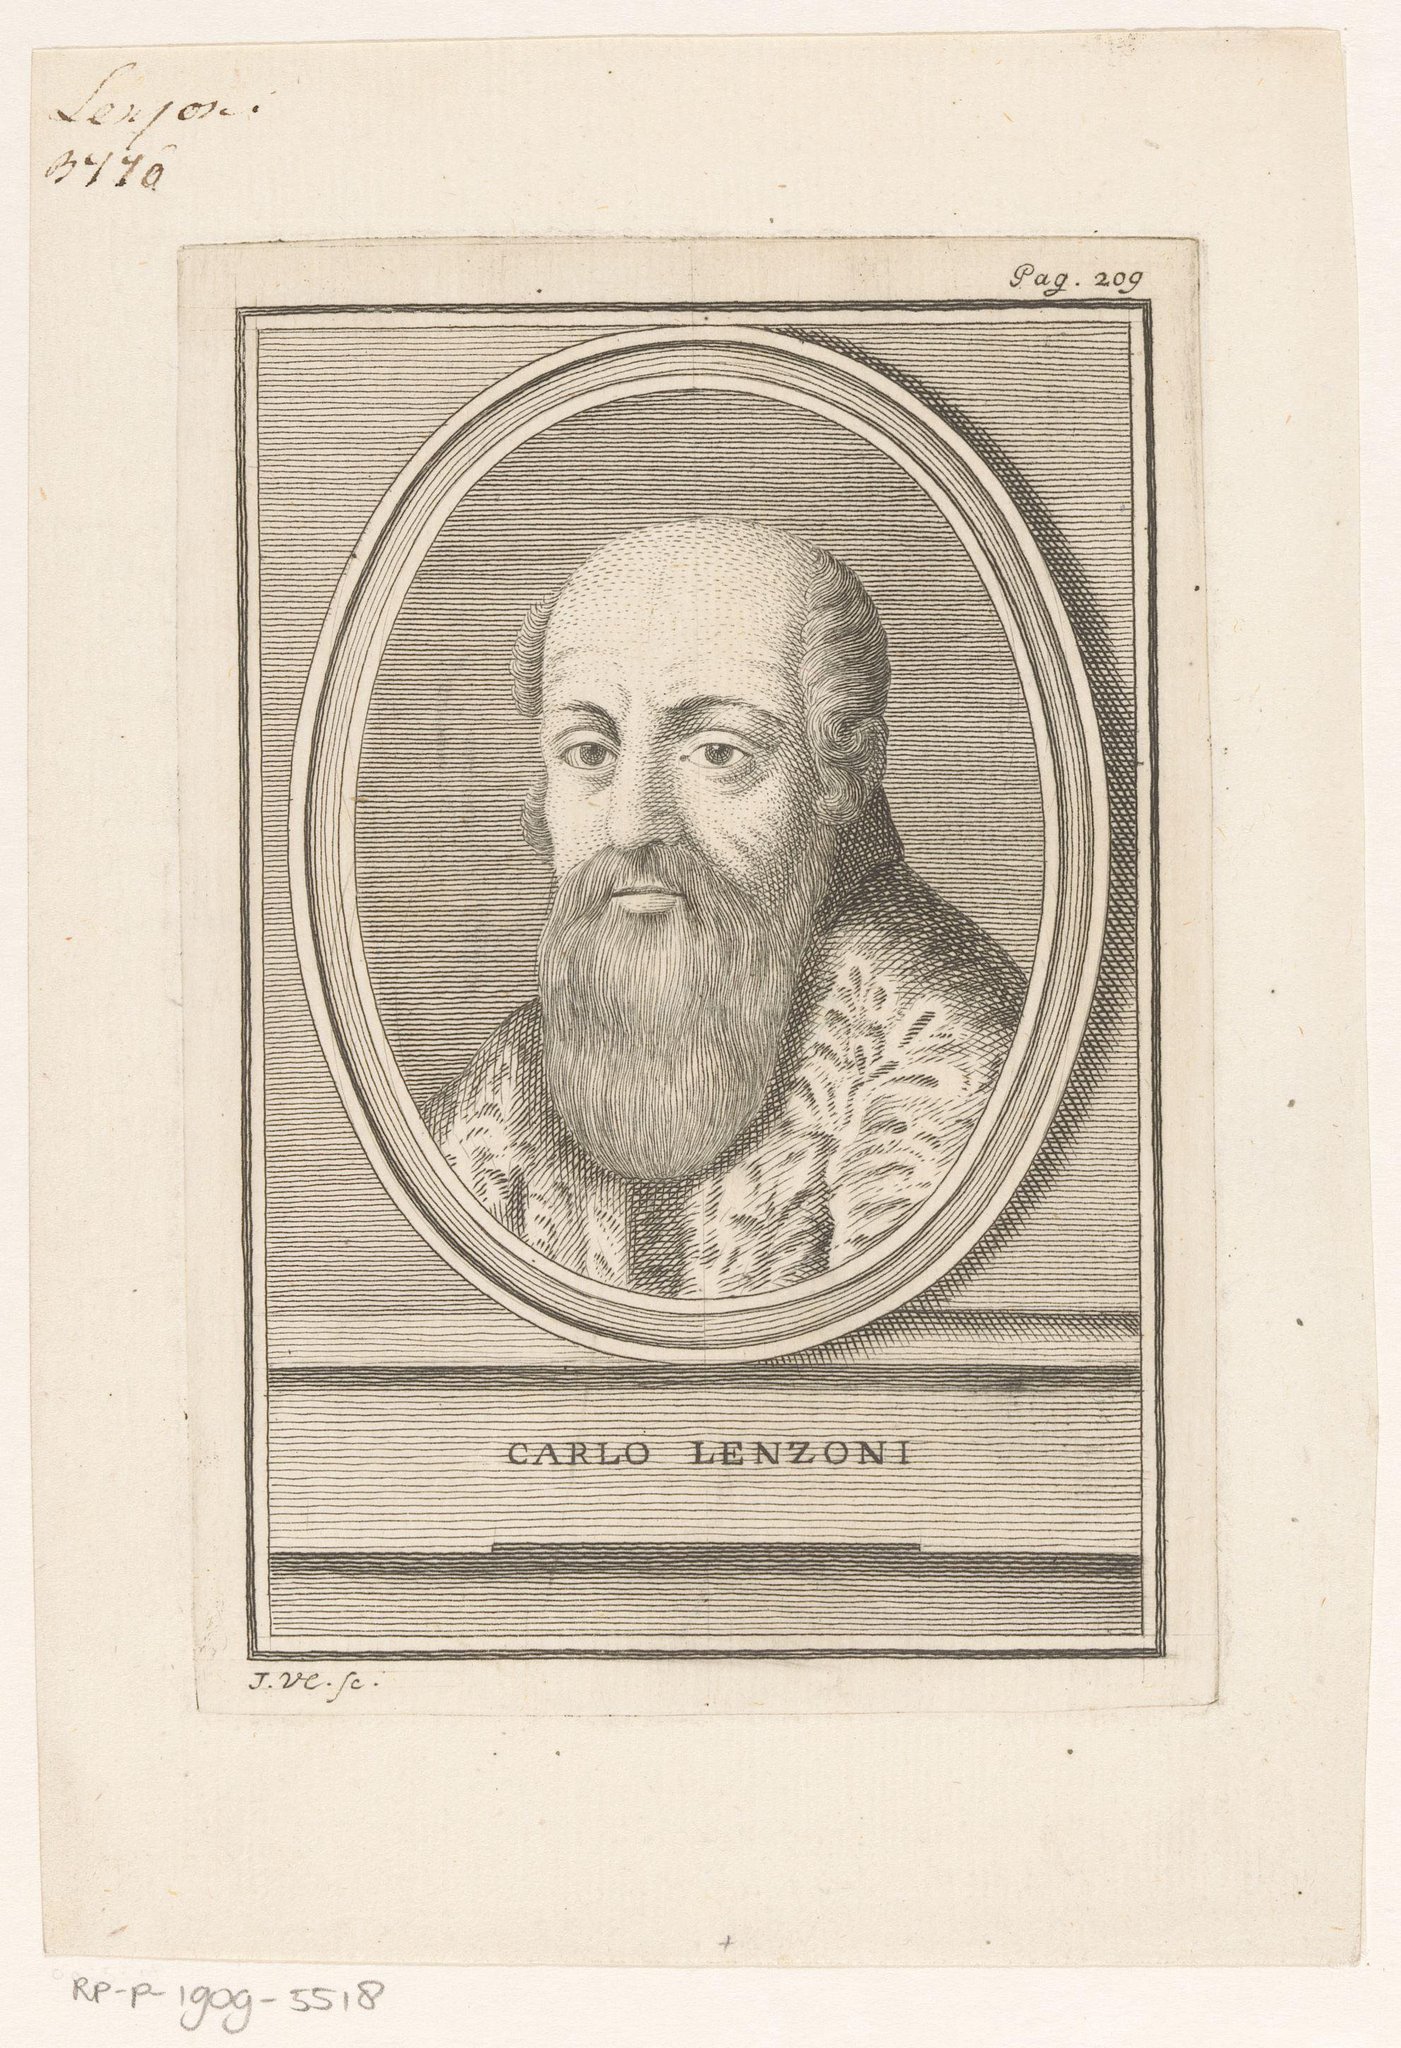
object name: print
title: Portret van liedschrijver Carlo Lenzóni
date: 1750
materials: paper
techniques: engraving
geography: lucca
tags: historical persons, portrait of a writer, writer, poet, author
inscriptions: inscription: ‘Lenzoni / 3770’, collector's mark: Lugt 2228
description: Prent gebruikt voor Grazzini, Anton Francesco. Tutti i trionfi, carri, mascherate o canti carnascialeschi andati per Firenze dal tempo del Magnifico Lorenzo de' Medici fino all' anno 1559 : in questa seconda edizione corretti, con diversi MSS. collazionati, delle loro varie lezioni arricchiti, notabilmente accresciuti, e co' ritratti di ciascun poeta adornate. Lucca: Cosmopoli, 1750.